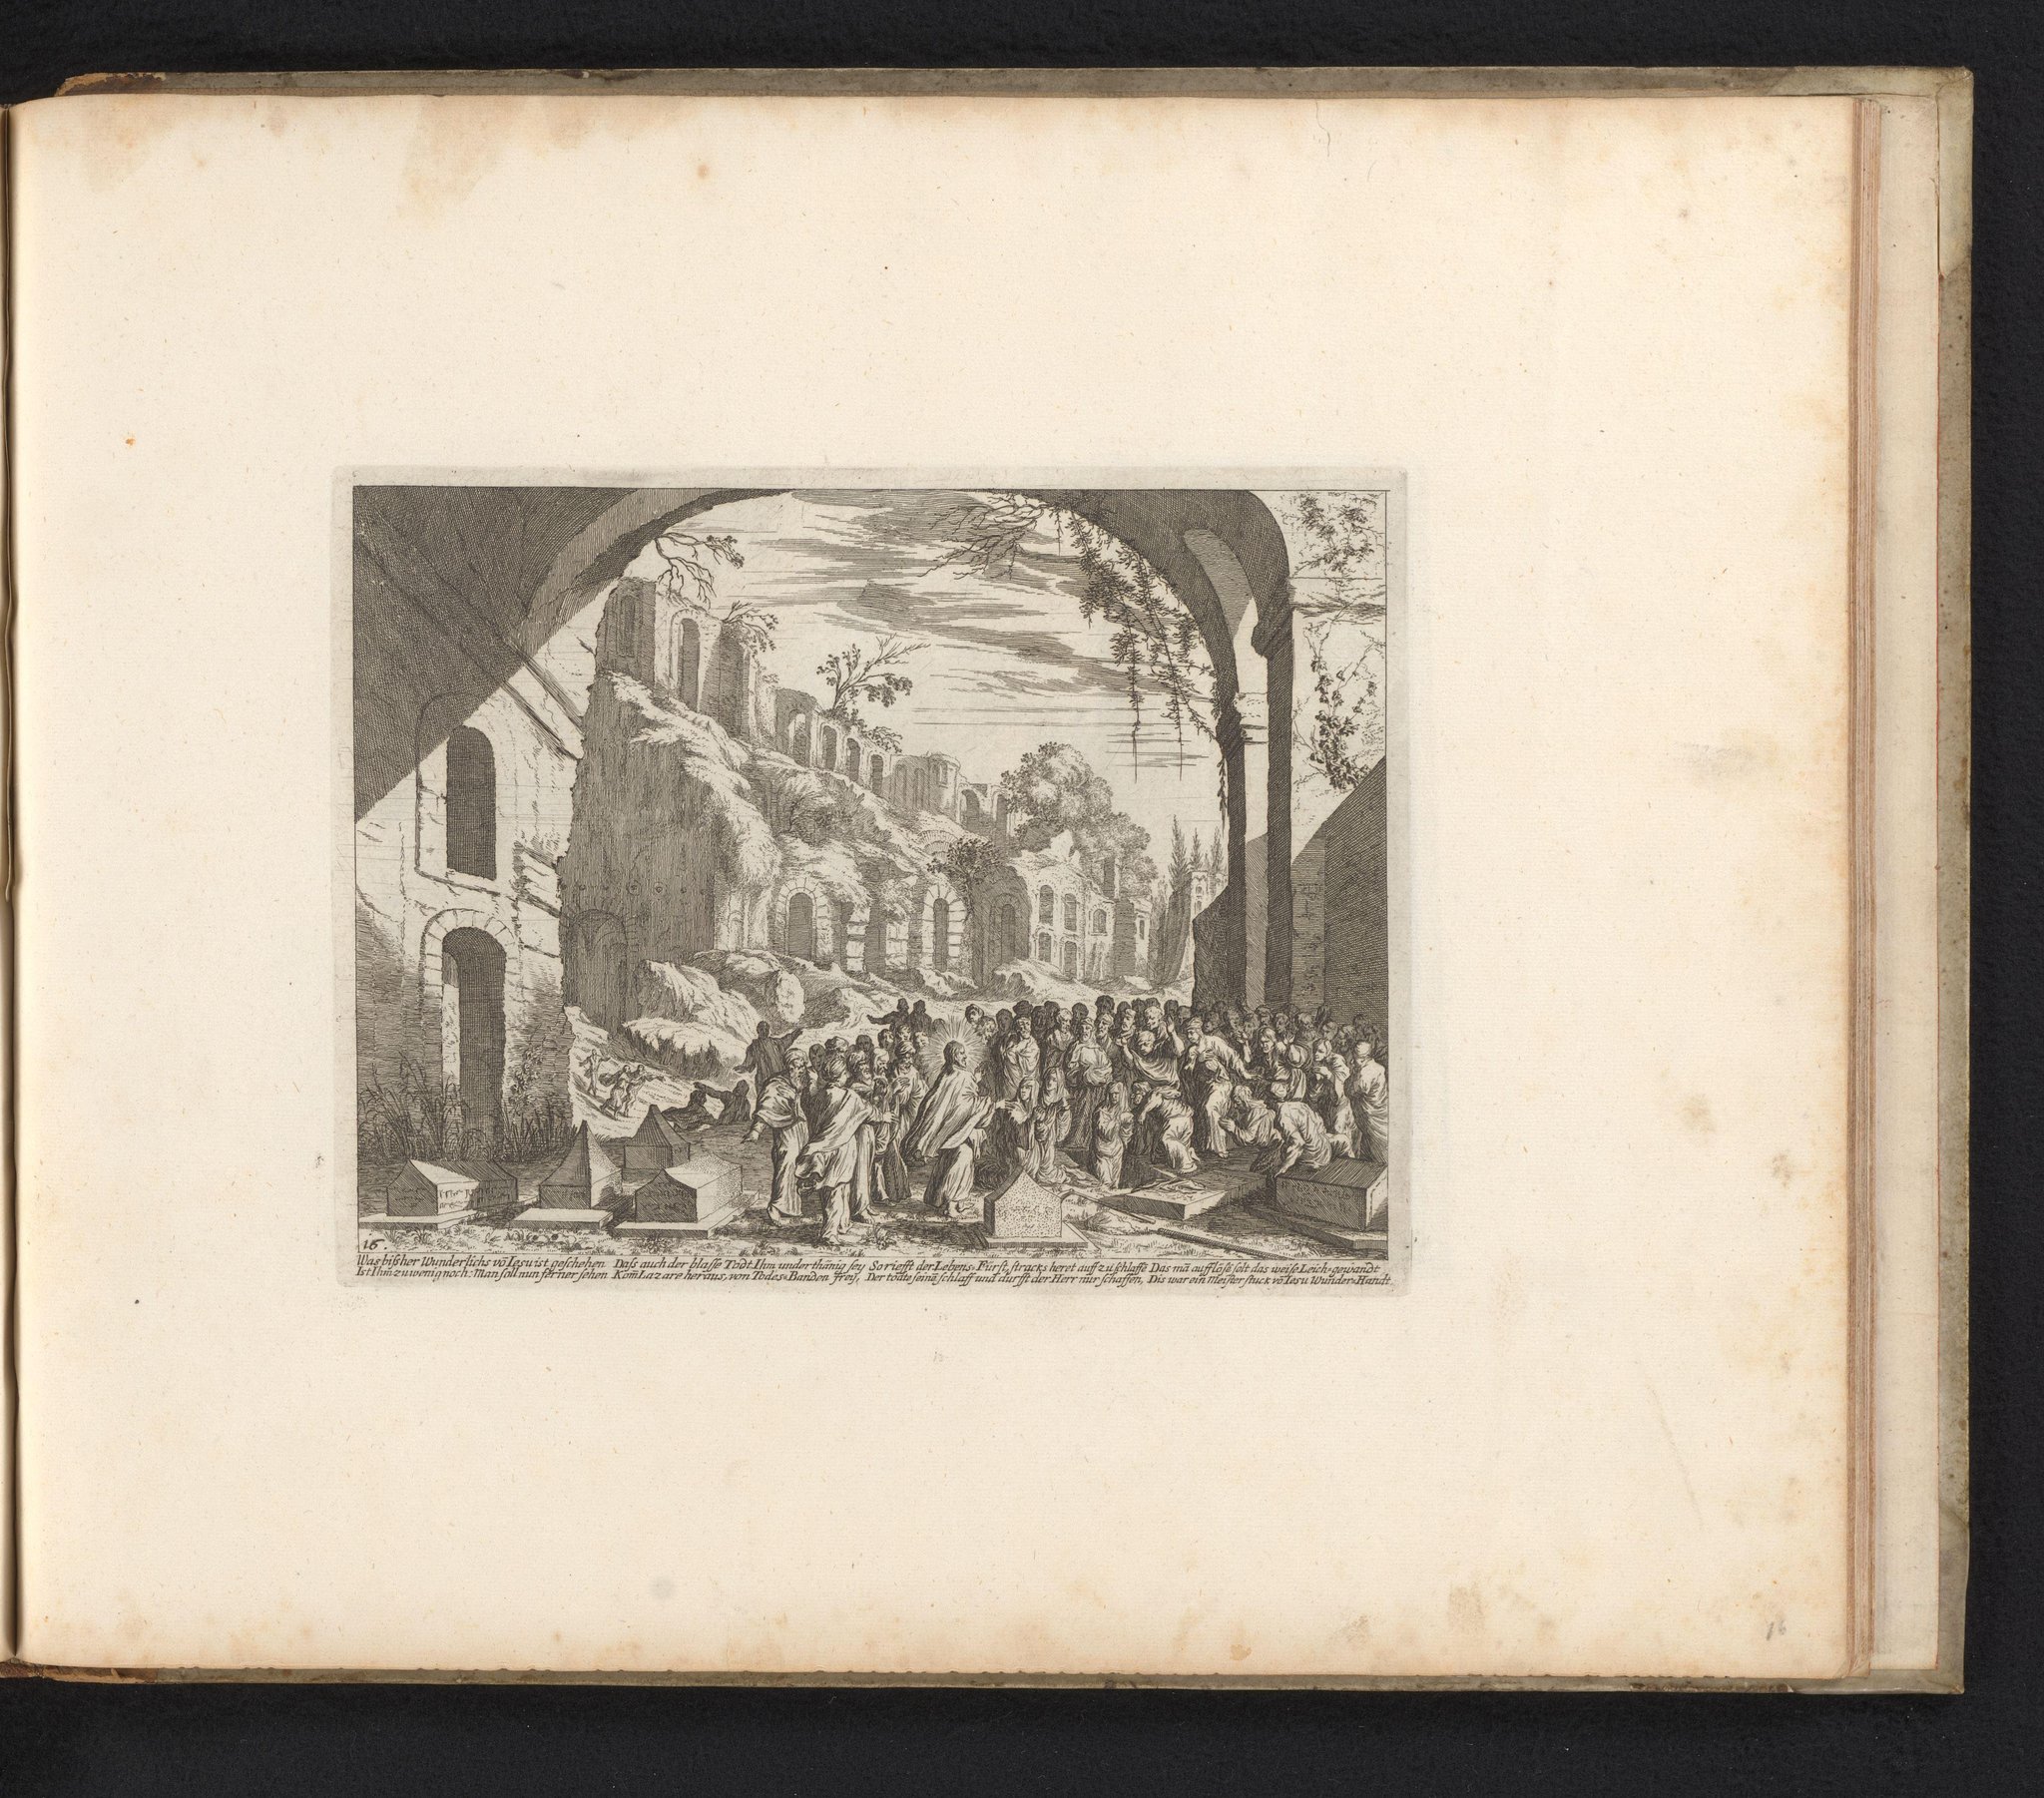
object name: album leaf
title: Opwekking van Lazarus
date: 1670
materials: paper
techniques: etching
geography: augsburg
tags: the raising of lazarus ('lazarus, come out')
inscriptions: collector's mark: Lugt 2228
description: Tekst in het Duits in de ondermarge. Linksonder genummerd: 16. Prent maakt deel uit van een album.